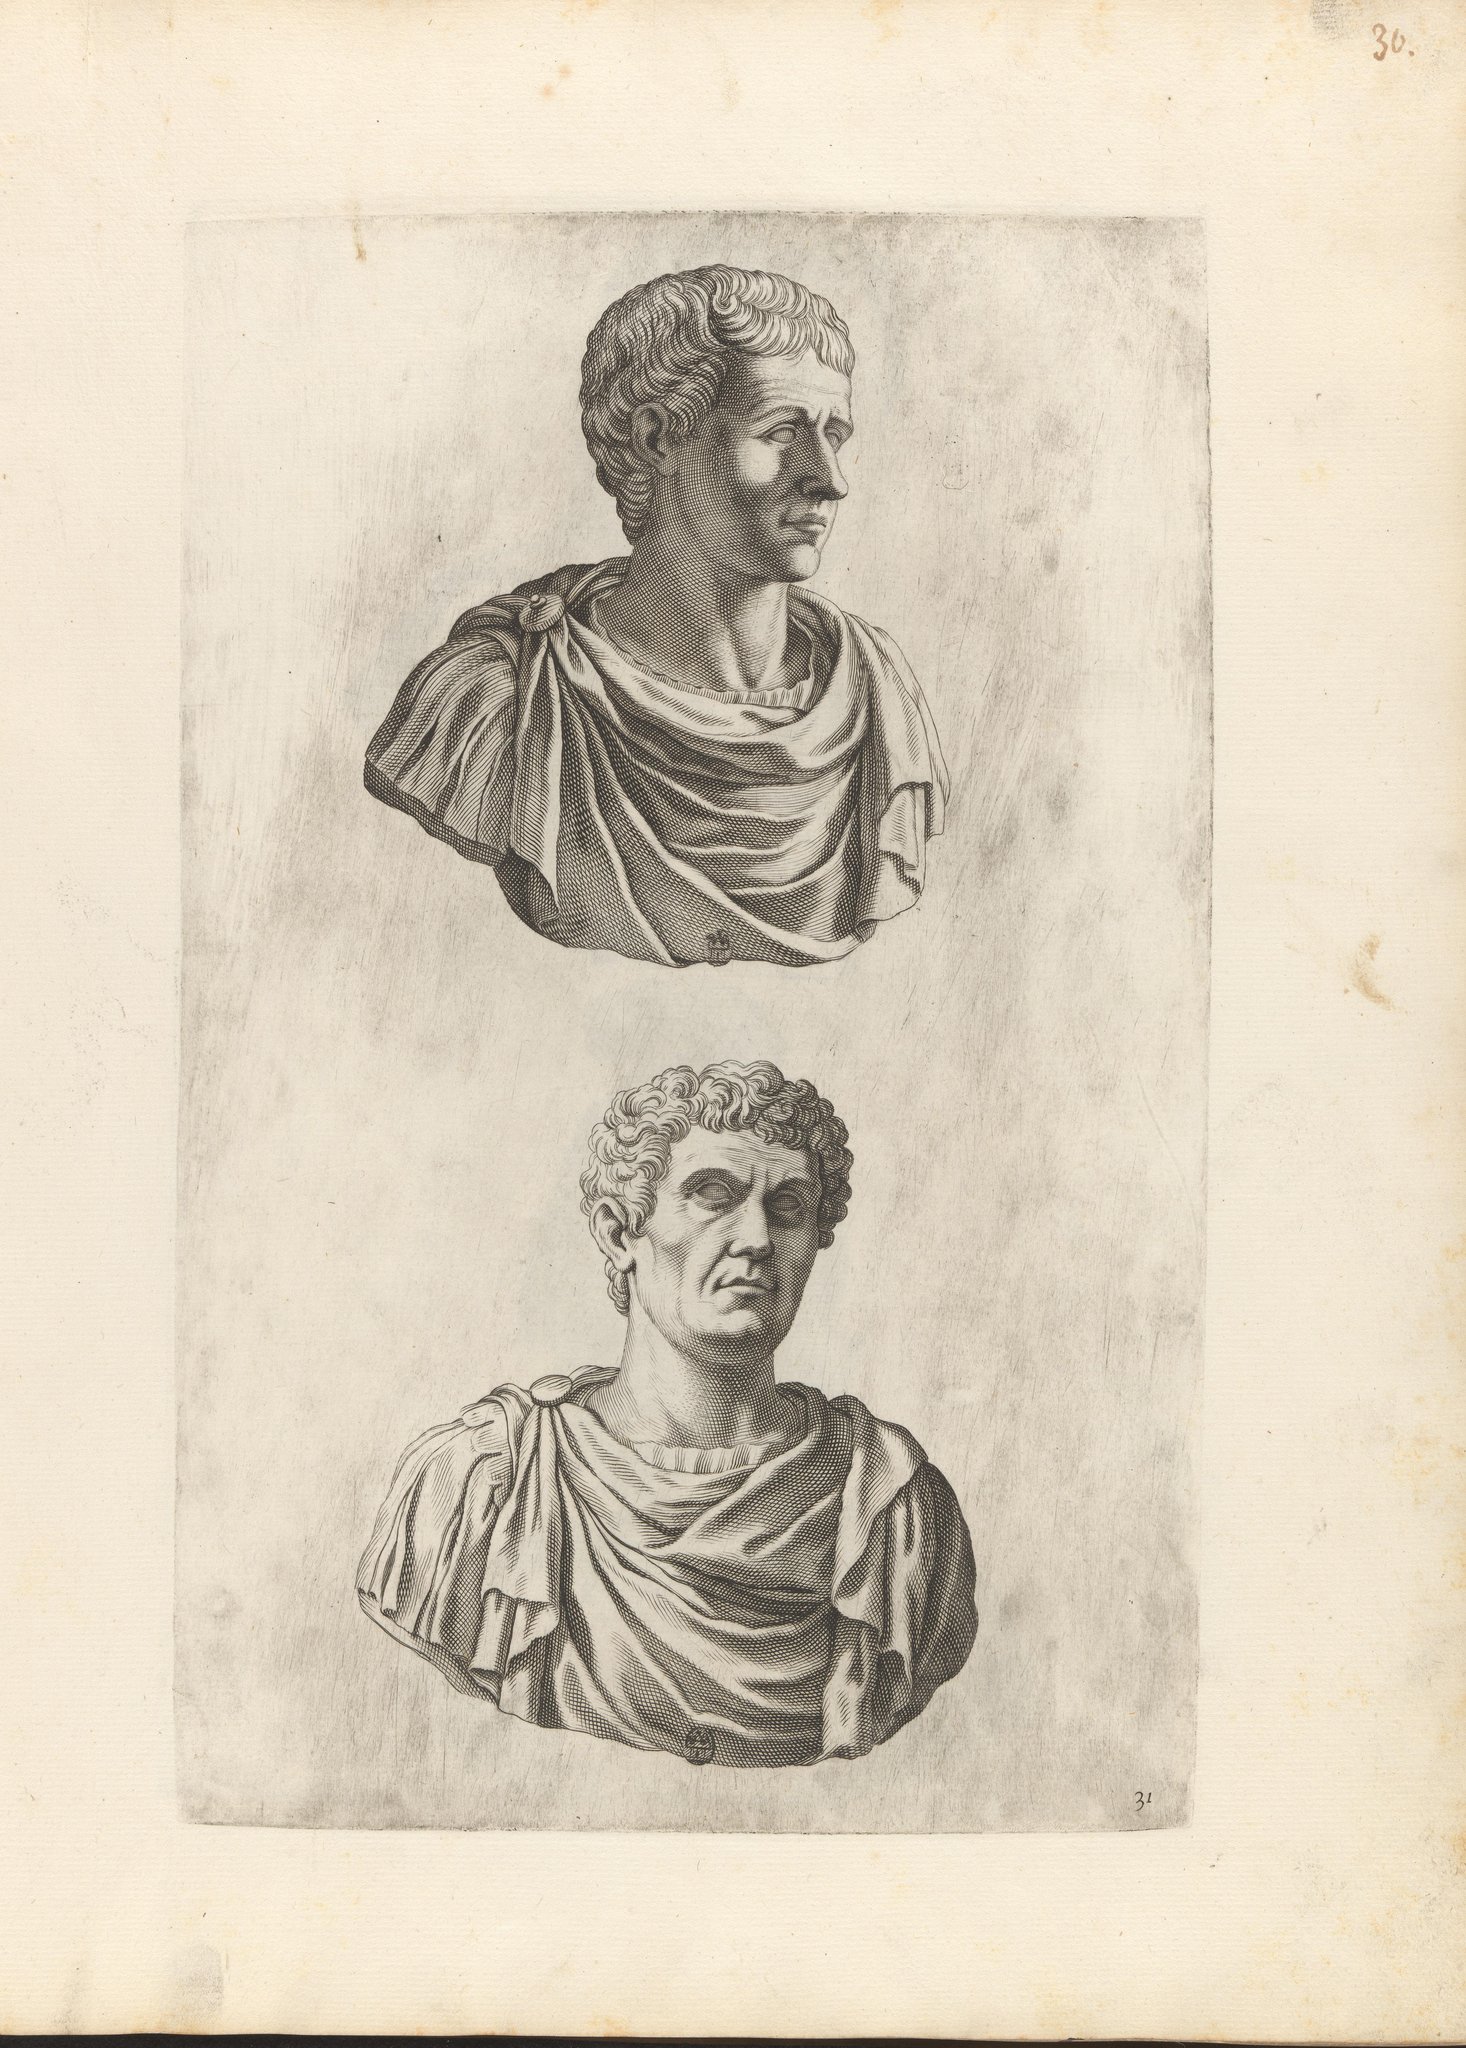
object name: print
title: Galleria Giustiniana del Marchese Vincenzo Giustiniani II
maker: michel natalis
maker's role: print maker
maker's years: 1610-1668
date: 1636-1647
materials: paper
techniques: engraving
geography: rome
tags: male persons from classical history (+ head, bust, etc.), piece of sculpture, reproduction of a piece of sculpture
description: Twee portretbustes van Marcus Vipsanius Agrippa. Op de bustes het wapenschild van Vincenzo Giustiniani. Prent maakt deel uit van een album met een serie prenten naar de sculpturen in de verzameling in de Galleria Giustiniani te Rome.